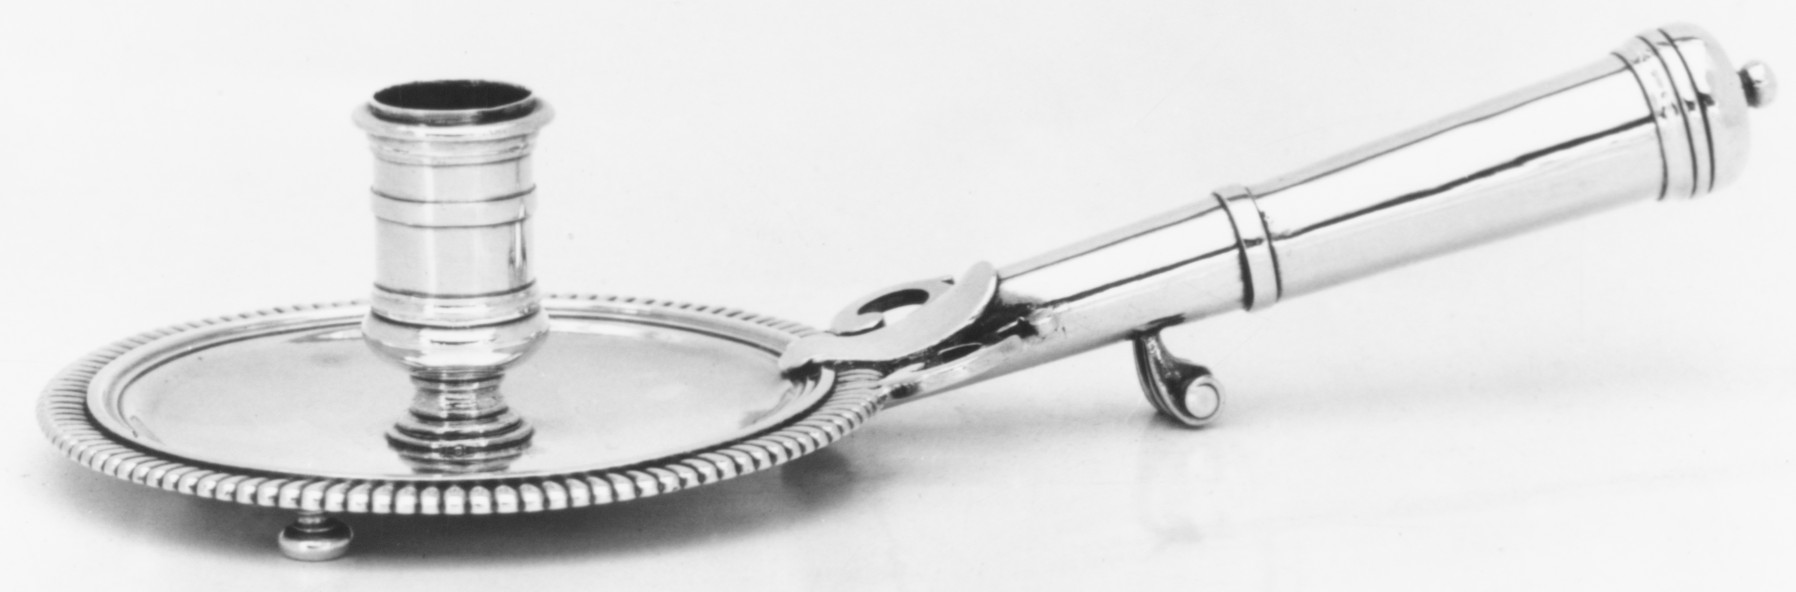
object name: chamber candlestick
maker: arnaud gautier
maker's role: maker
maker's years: 1647-1723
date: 1699-1700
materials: silver